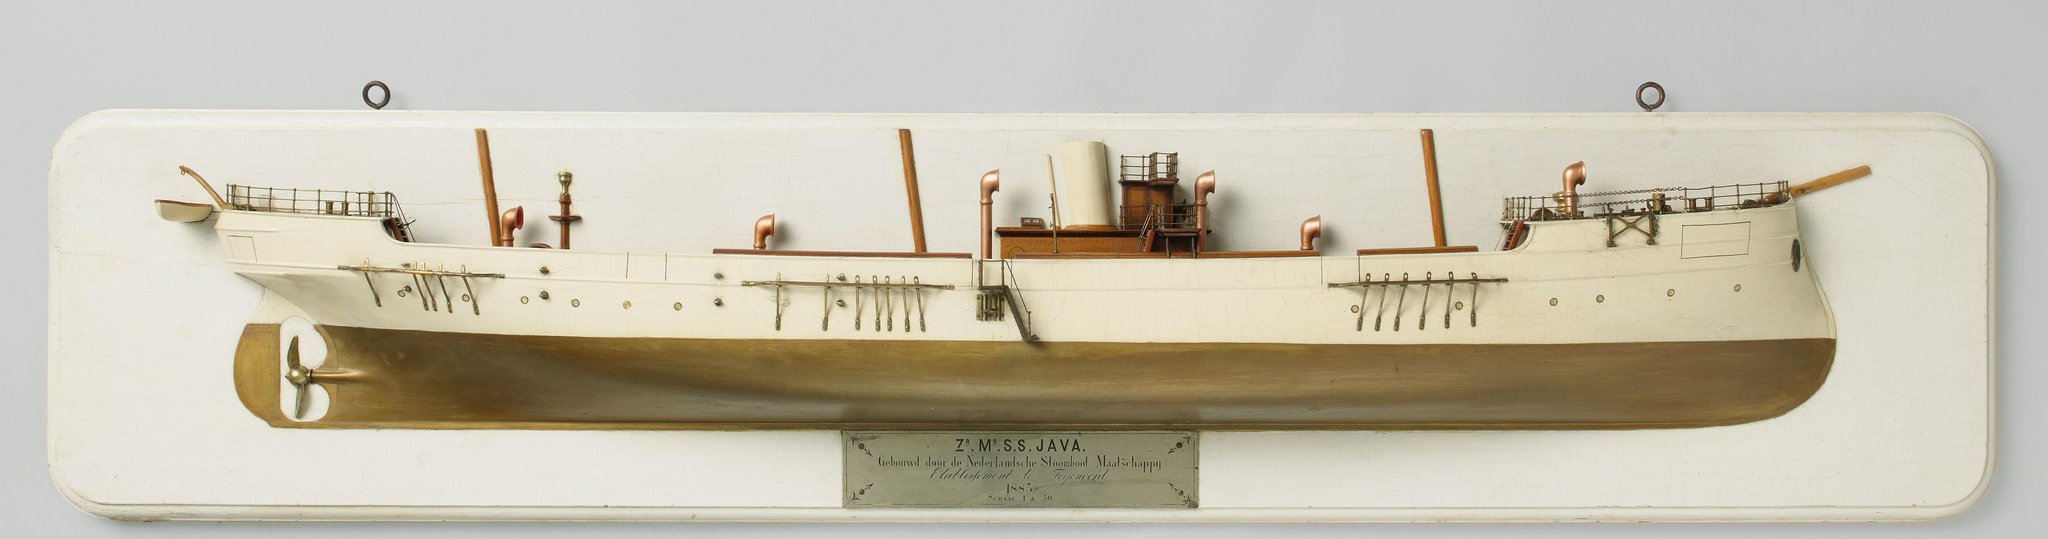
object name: ship model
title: Half Model of a Screw Steamer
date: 1885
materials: brass, wood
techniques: polychromy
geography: rotterdam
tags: java (schip)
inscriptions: inscription, bottom centre, on a rectangular metal label: ‘Zr. Ms. S.S. JAVA. / Gebouwd door de Nederlandsche Stoomboot Maatschappij / Etablissement te Feijenoord / 1885 / SCHAAL 1 A 50.’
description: Het schroefstoomschip 4de klasse van 8 stukken Java, lang 59 m, werd bij de Nederlandsche Stoomboot Maatschappij Feijenoord gebouwd in 1885. Zij was composiet gebouwd. Zij deed alleen dienst in Oost-Indië, waar zij in 1904 uit dienst gesteld werd en het jaar daarop aan de Gouvernementsmarine overgedragen; in 1906-1910 nam het schip deel aan de Lorentz-expeditie in Nederlands Nieuw Guinea.